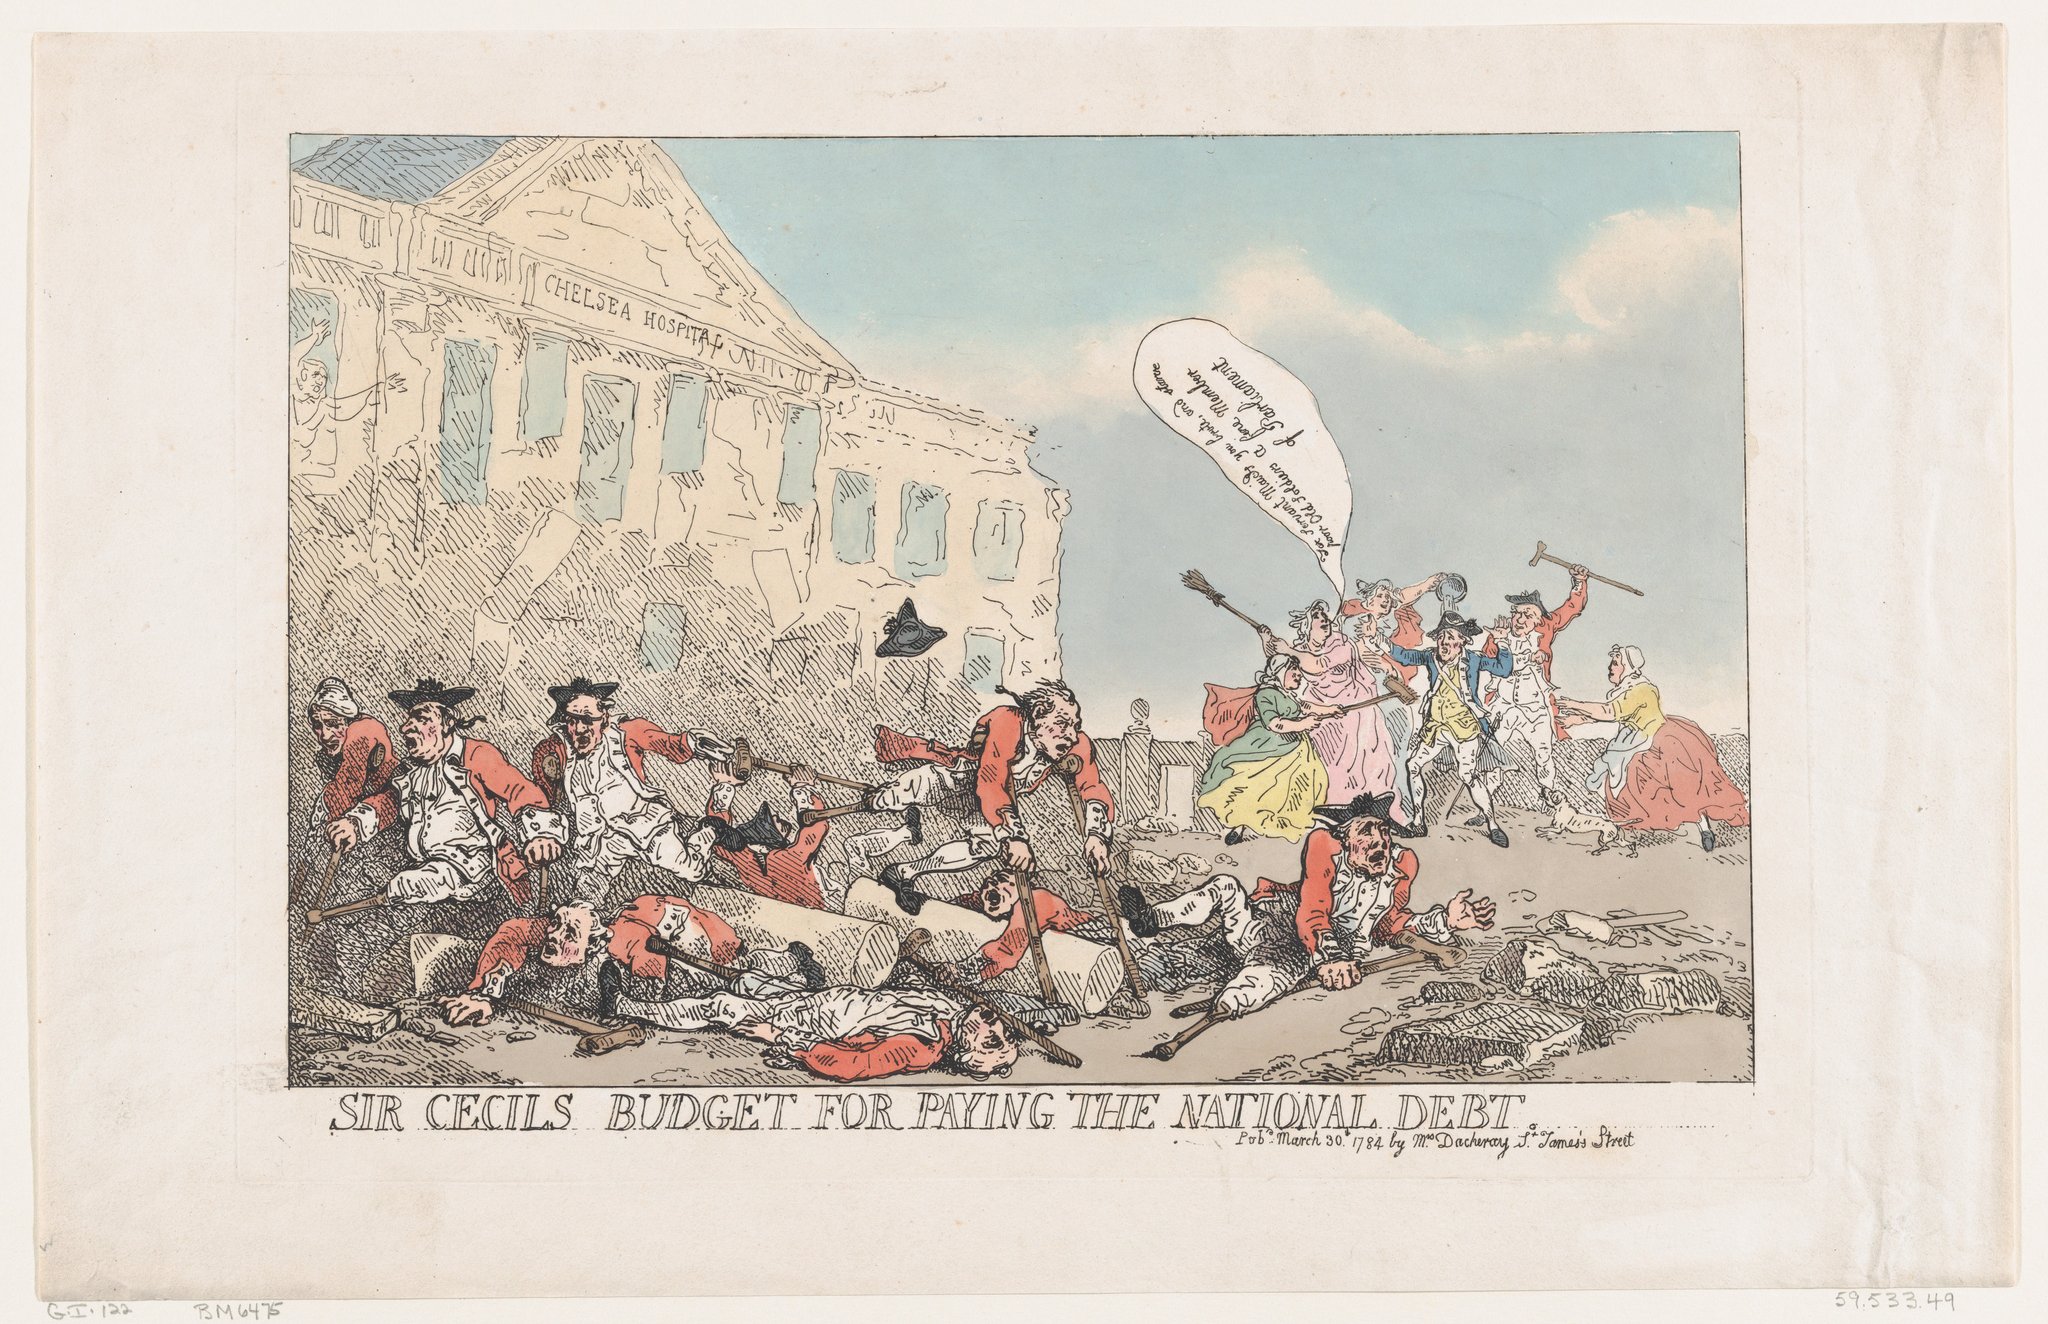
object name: print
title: Sir Cecils Budget For Paying The National Debt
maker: thomas rowlandson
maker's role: artist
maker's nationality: british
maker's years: 1757-1827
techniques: etching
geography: london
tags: satire,men,women,crowd